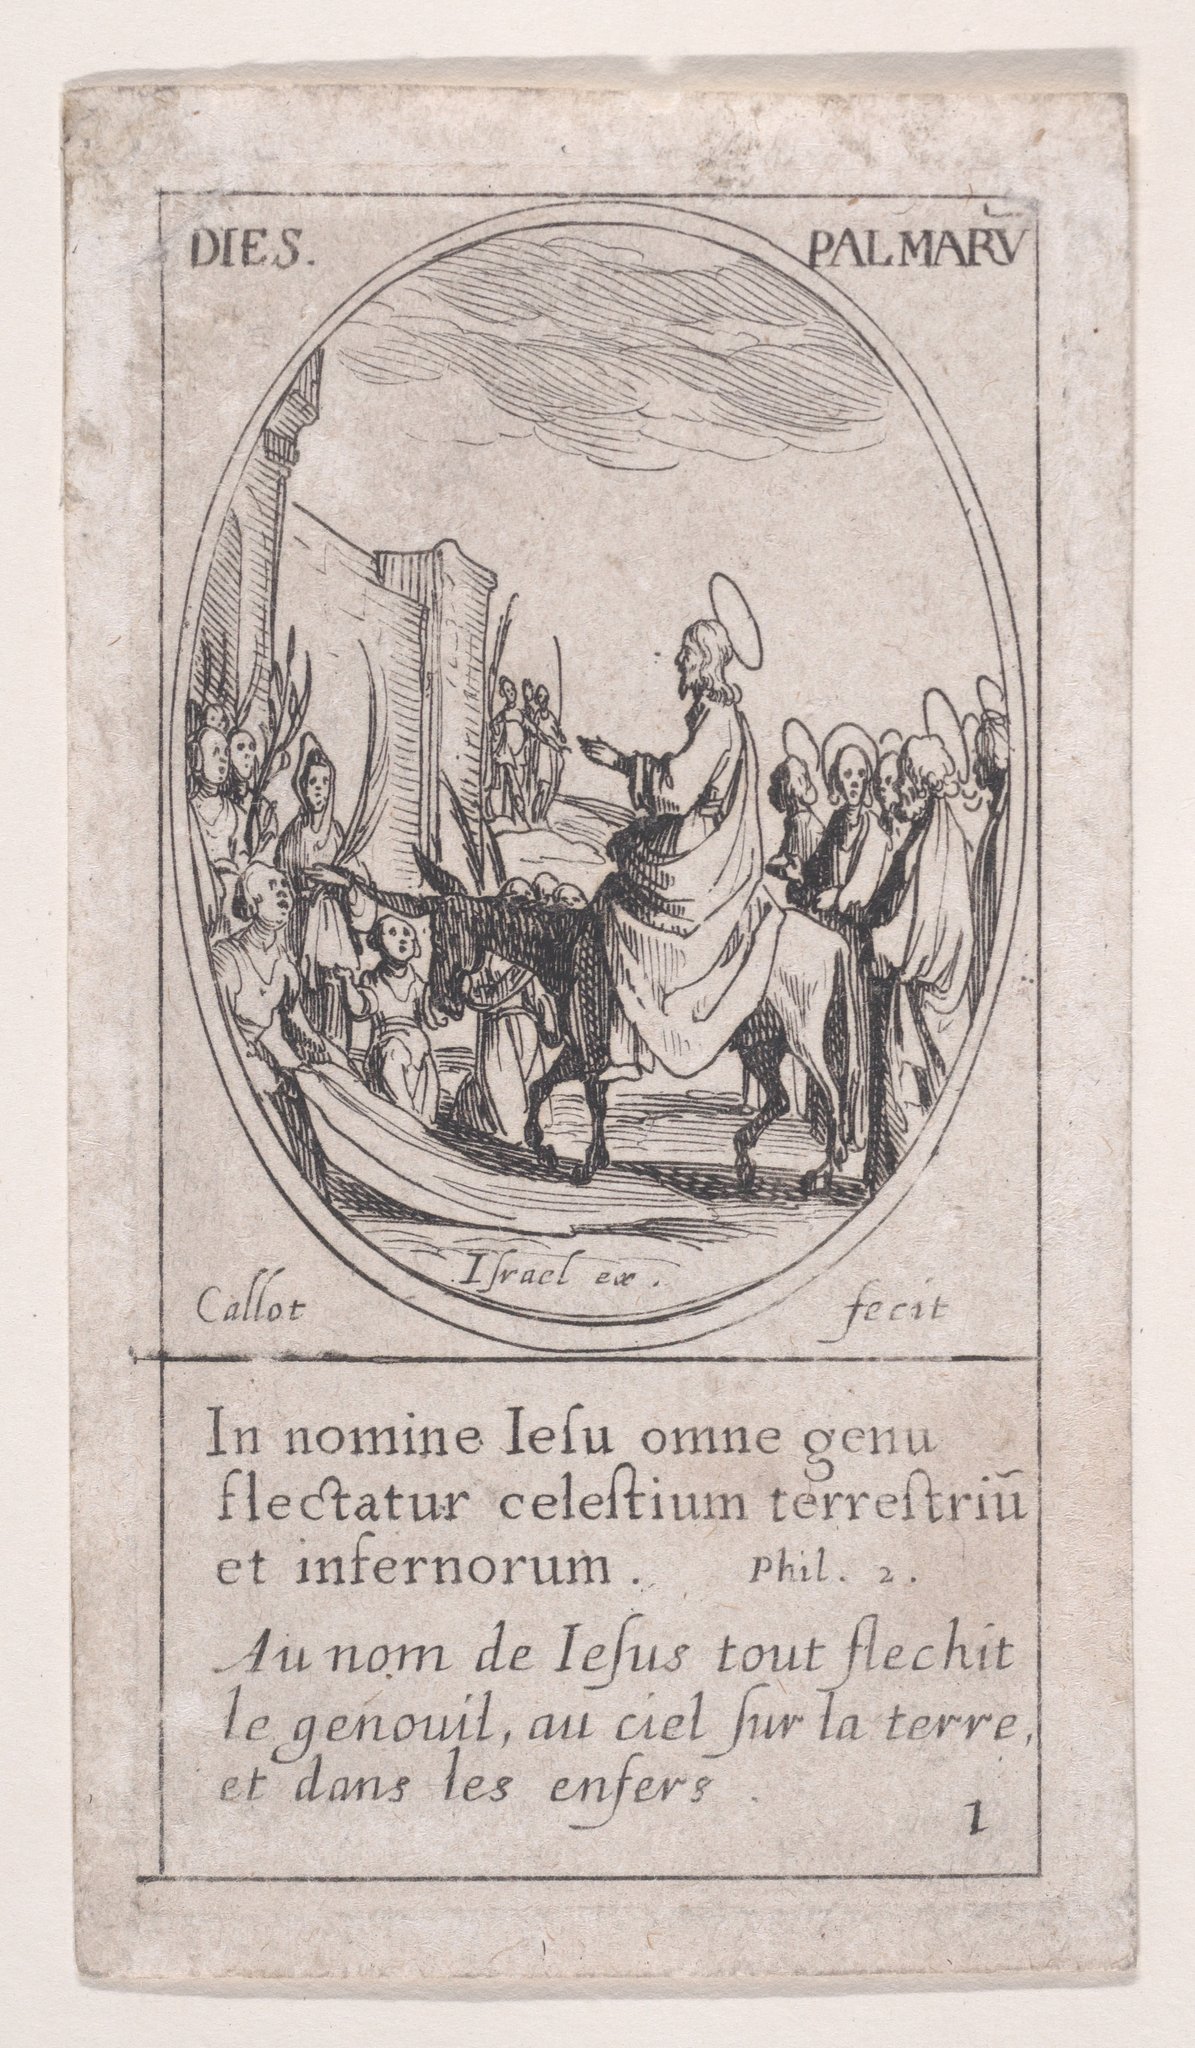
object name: print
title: Notre-Seignure fait son entrée dans Jérusalem (Christ Enters Jerusalem), Palm Sunday, scene 1 from Images des Fêtes Mobiles (Images of Moveable Feasts from the Christian Calendar), part of "Les Images De Tous Les Saincts et Saintes de L'Année" (Images of All of the Saints and Religious Events of the Year)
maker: jacques callot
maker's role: artist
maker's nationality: french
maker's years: 1592-1635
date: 1632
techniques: etching